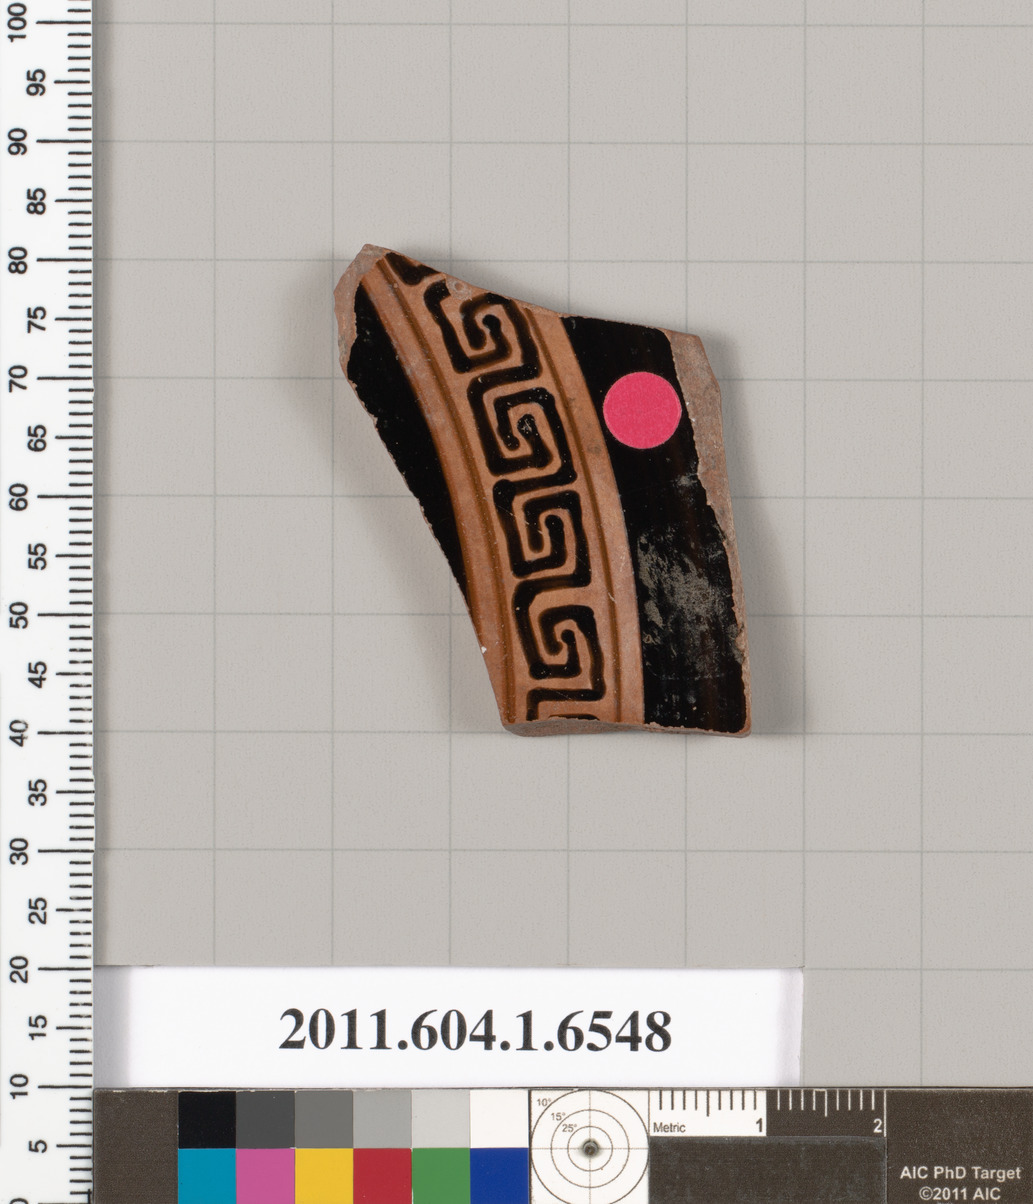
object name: kylix fragment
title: Terracotta fragment of a kylix (drinking cup)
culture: greek, attic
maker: colmar painter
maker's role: artist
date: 490-480 BCE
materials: terracotta